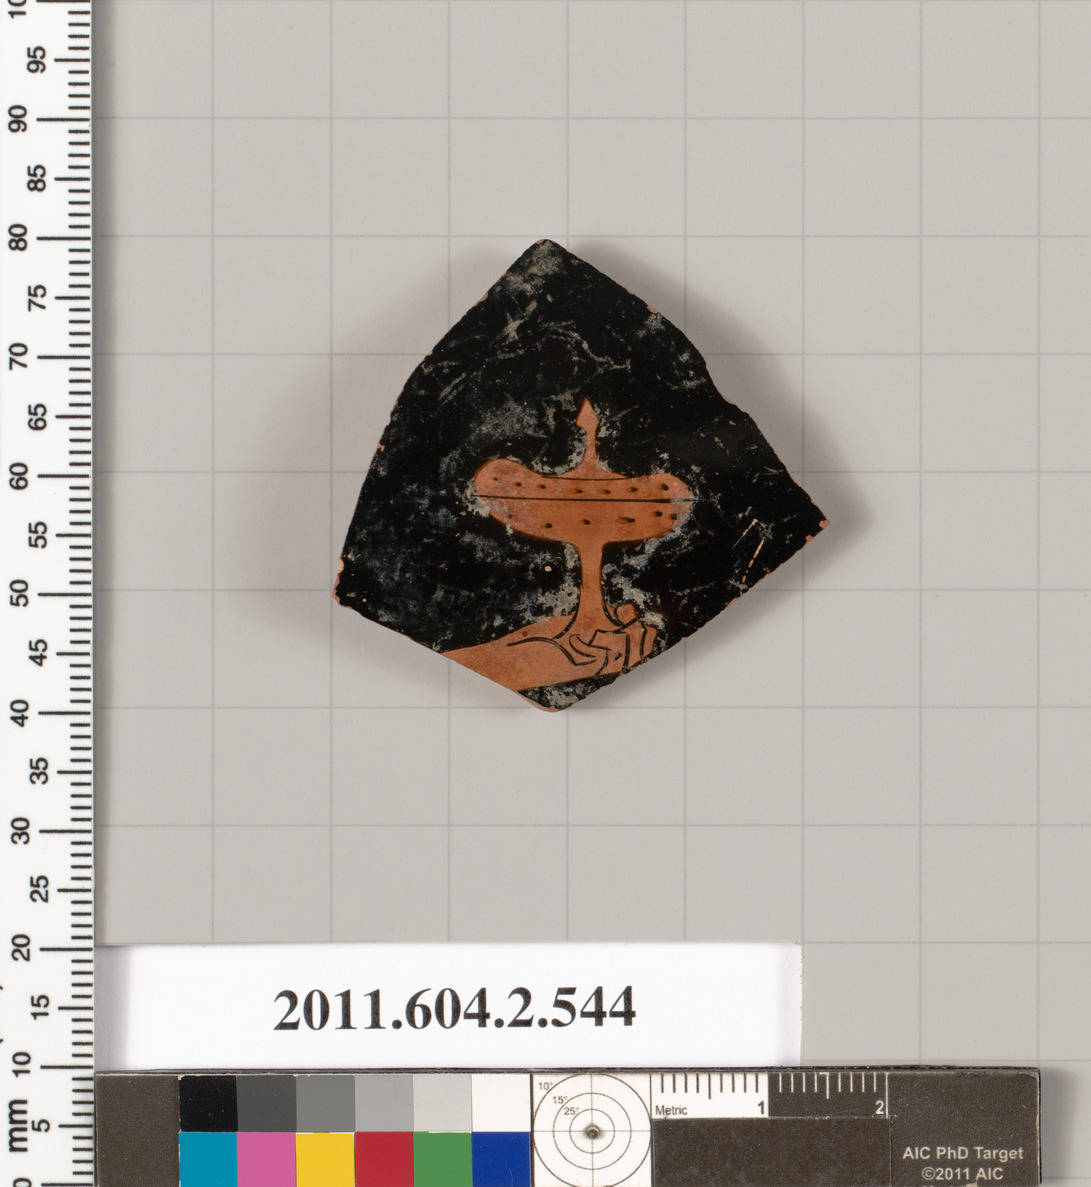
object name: column krater fragment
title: Terracotta fragment of a column-krater (bowl for mixing wine and water)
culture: greek, attic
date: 475-451 BCE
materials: terracotta